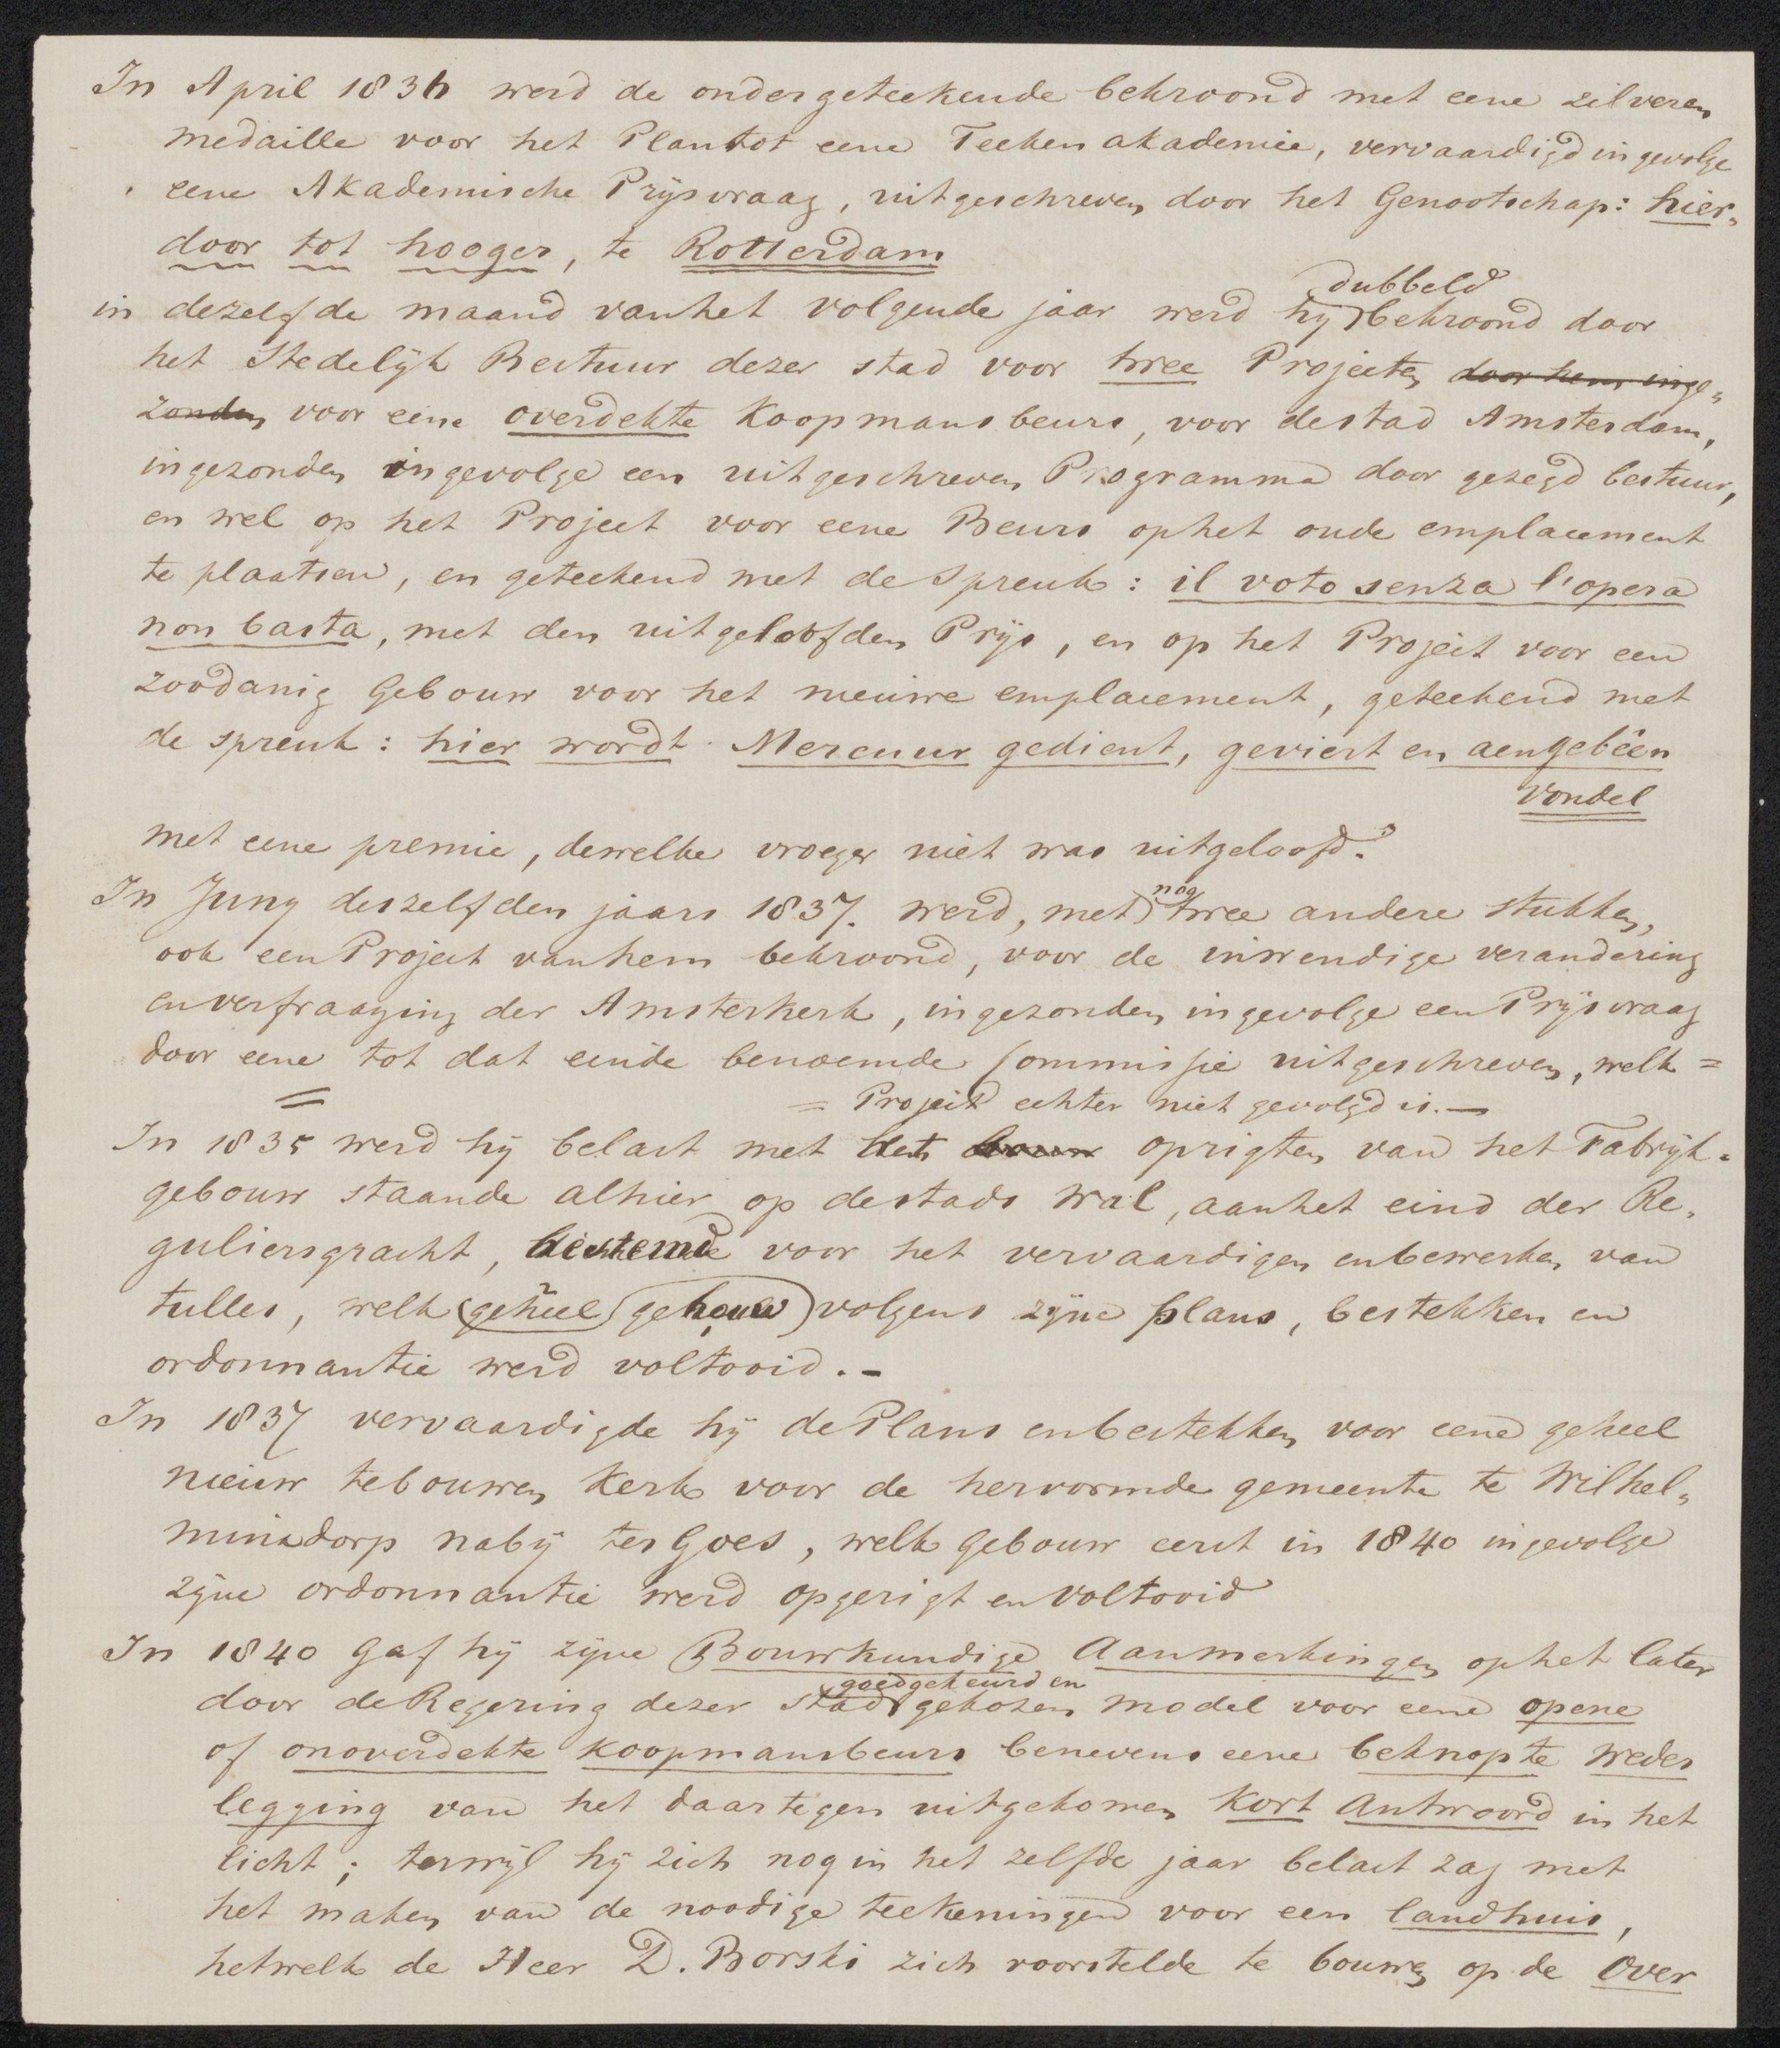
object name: manuscript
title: Autobiografie van Isaac Warnsinck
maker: isaac warnsinck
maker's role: architect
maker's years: 1811-1857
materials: ink, paper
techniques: pen, writing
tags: isaac warnsinck, education, tuition of the artist (in general), architecture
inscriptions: watermark